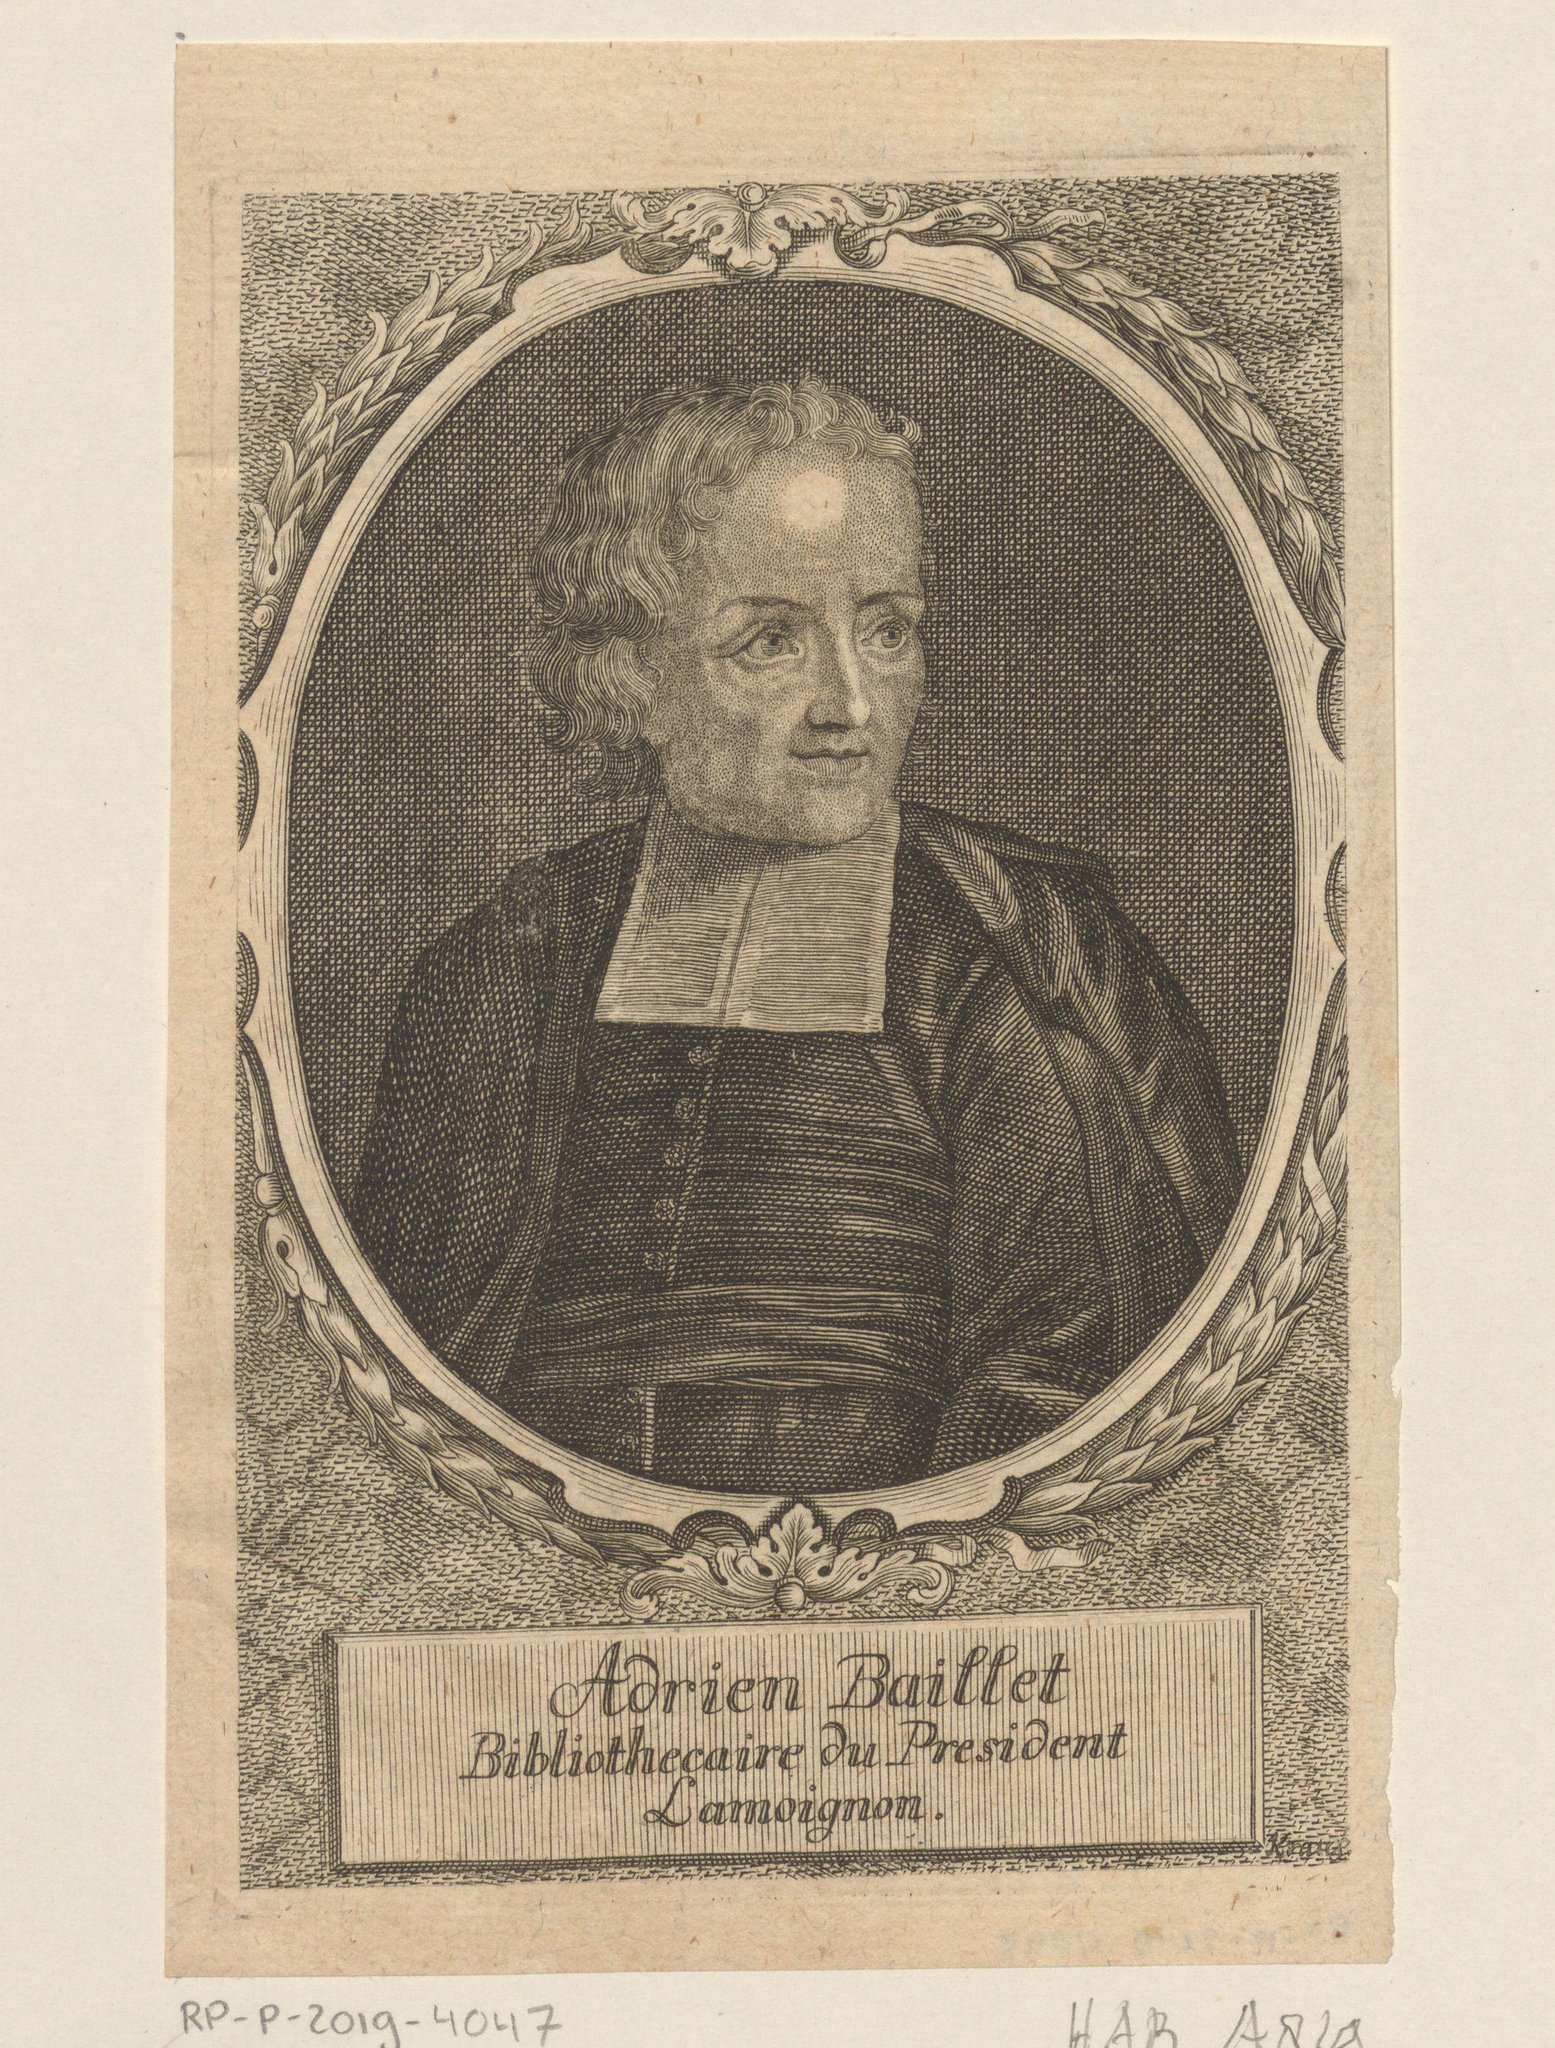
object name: book illustration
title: Portret van Adrien Baillet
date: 1715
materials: paper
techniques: engraving, etching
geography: leipzig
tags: paris, historical persons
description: Prent uit: Neuer Bücher-Saal der Gelehrten Welt (...). Leipzig: Johann Ludwig Gleditsch en Moritz Georg Weidmann, 1715, dl. 49.